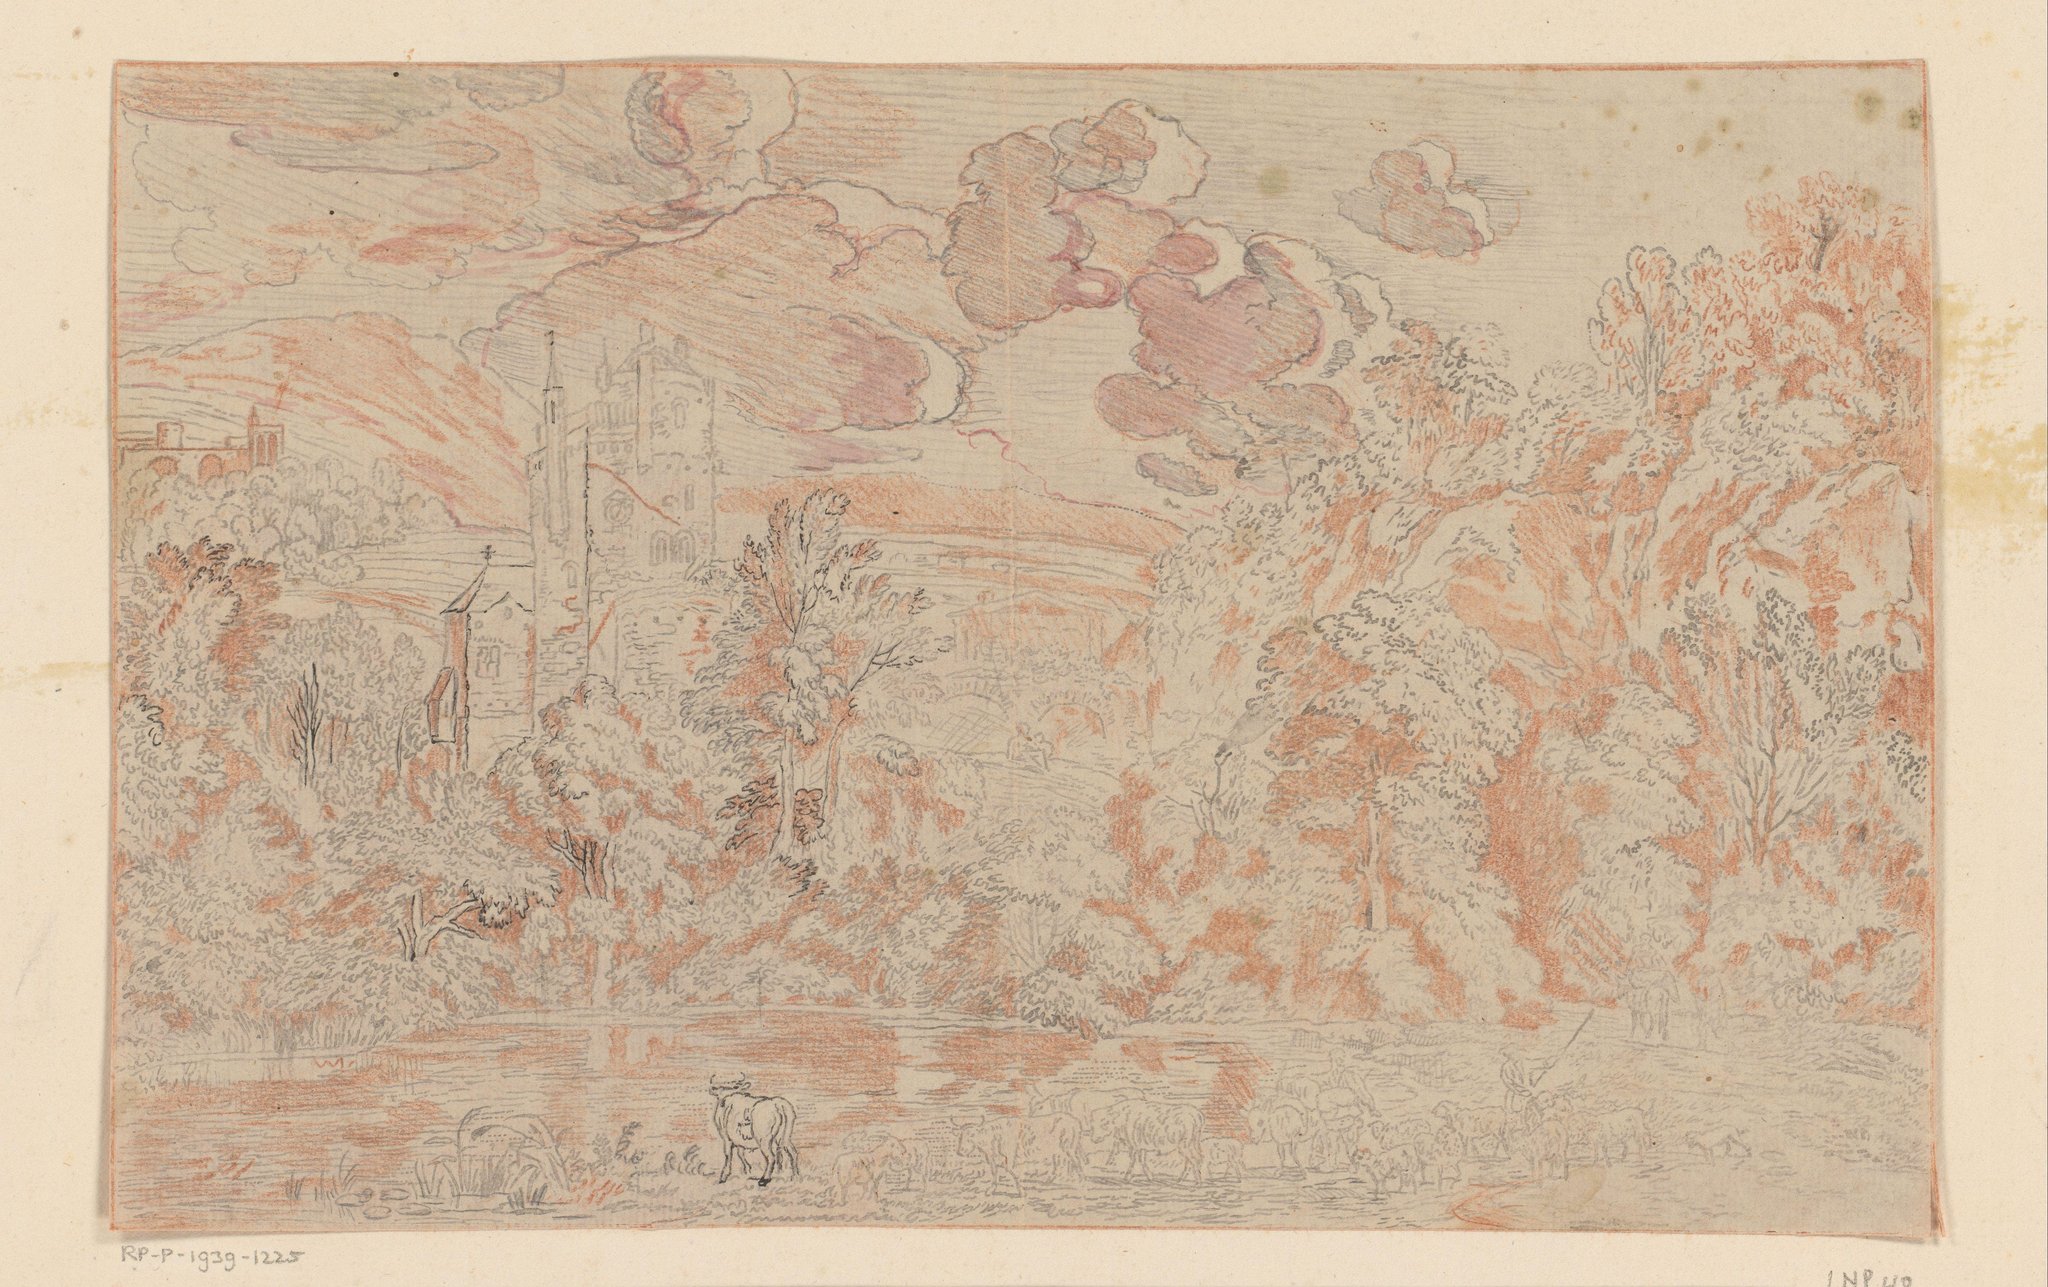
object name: drawing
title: Vallei met een kasteel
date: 1784-1786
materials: chalk, ink, paper, pencil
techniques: brush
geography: amsterdam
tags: castle, lake, cattle driving, cattle driver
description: Landschap met achter het geboomte een kasteel. Op de voorgrond veedrijvers met koeien en schapen bij een meer. De doordruktekening ligt los in een album, zie blad 40.